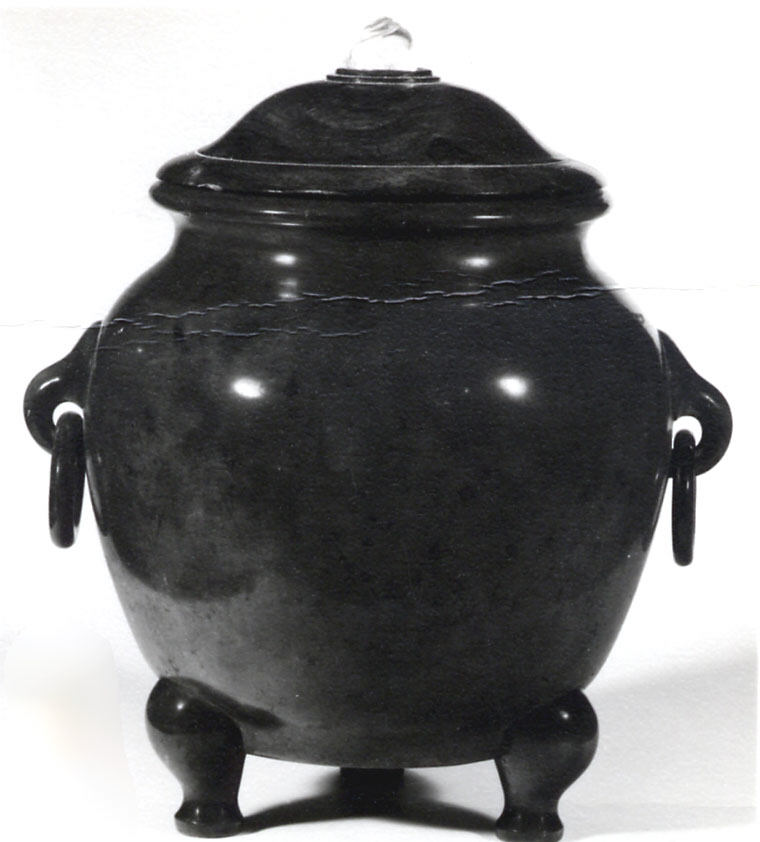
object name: covered jar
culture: chinese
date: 1368-1644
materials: bronze, glass, wood